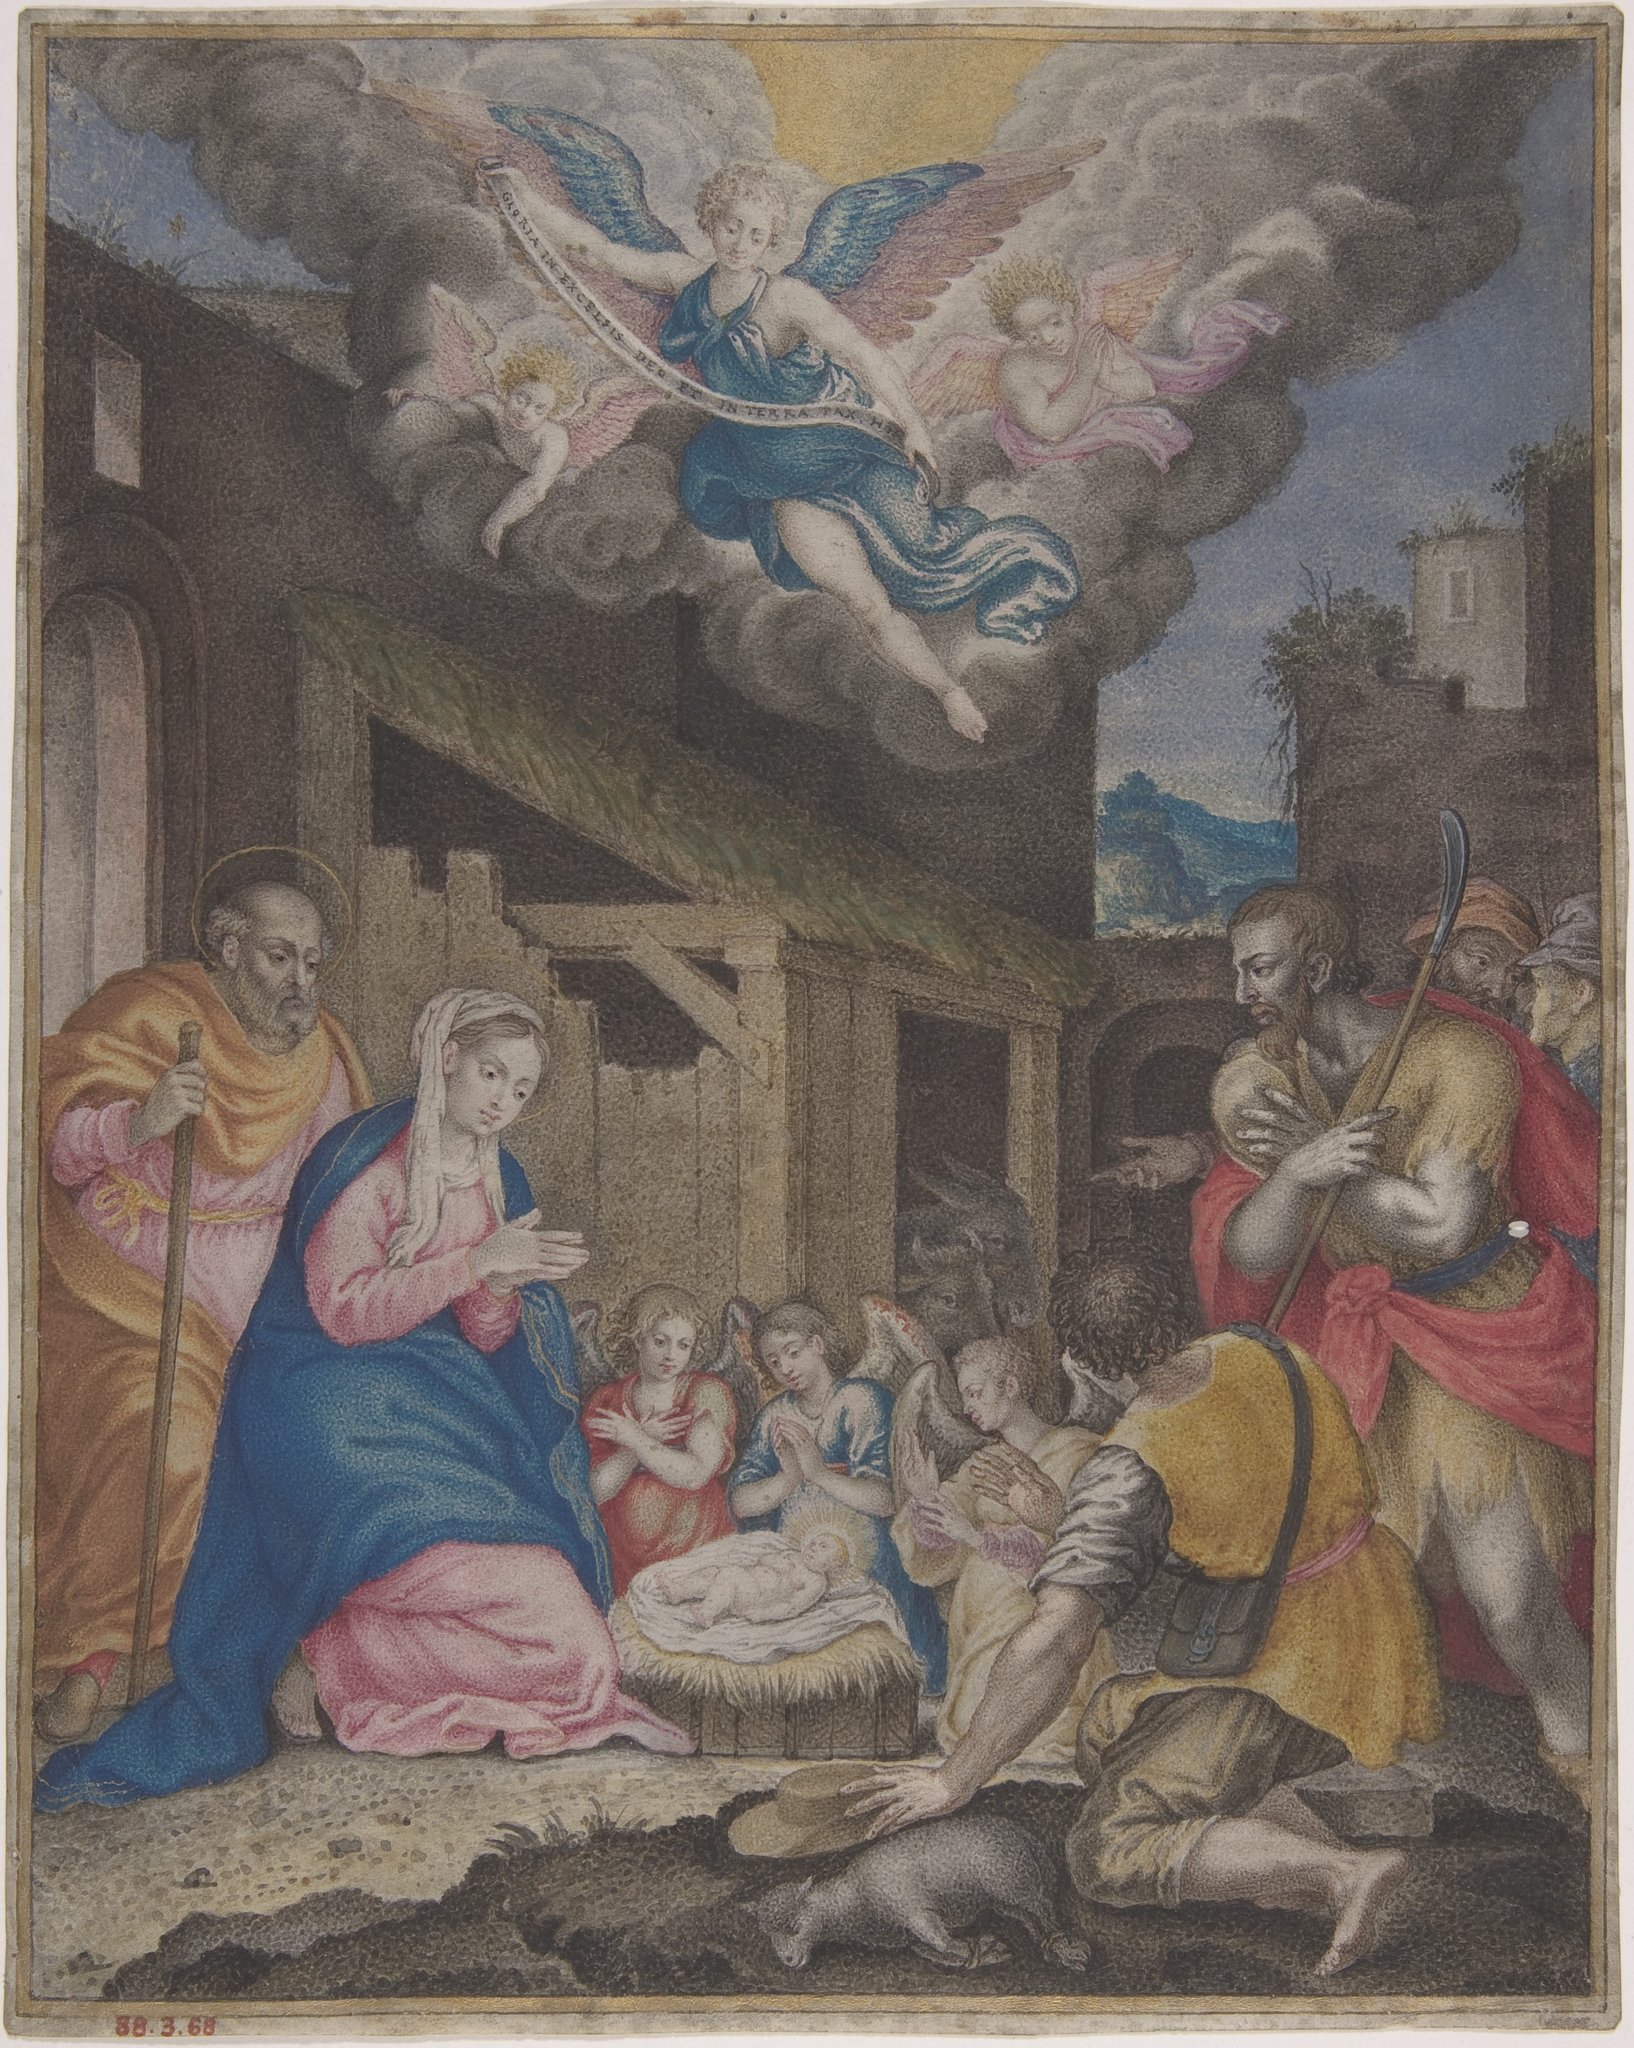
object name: drawing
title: Adoration of the Shepherds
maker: anonymous, italian, cremonese, 16th century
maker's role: artist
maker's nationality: italian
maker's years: 1500-1600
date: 1575-1600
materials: gouache, parchment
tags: angels,adoration of the shepherds